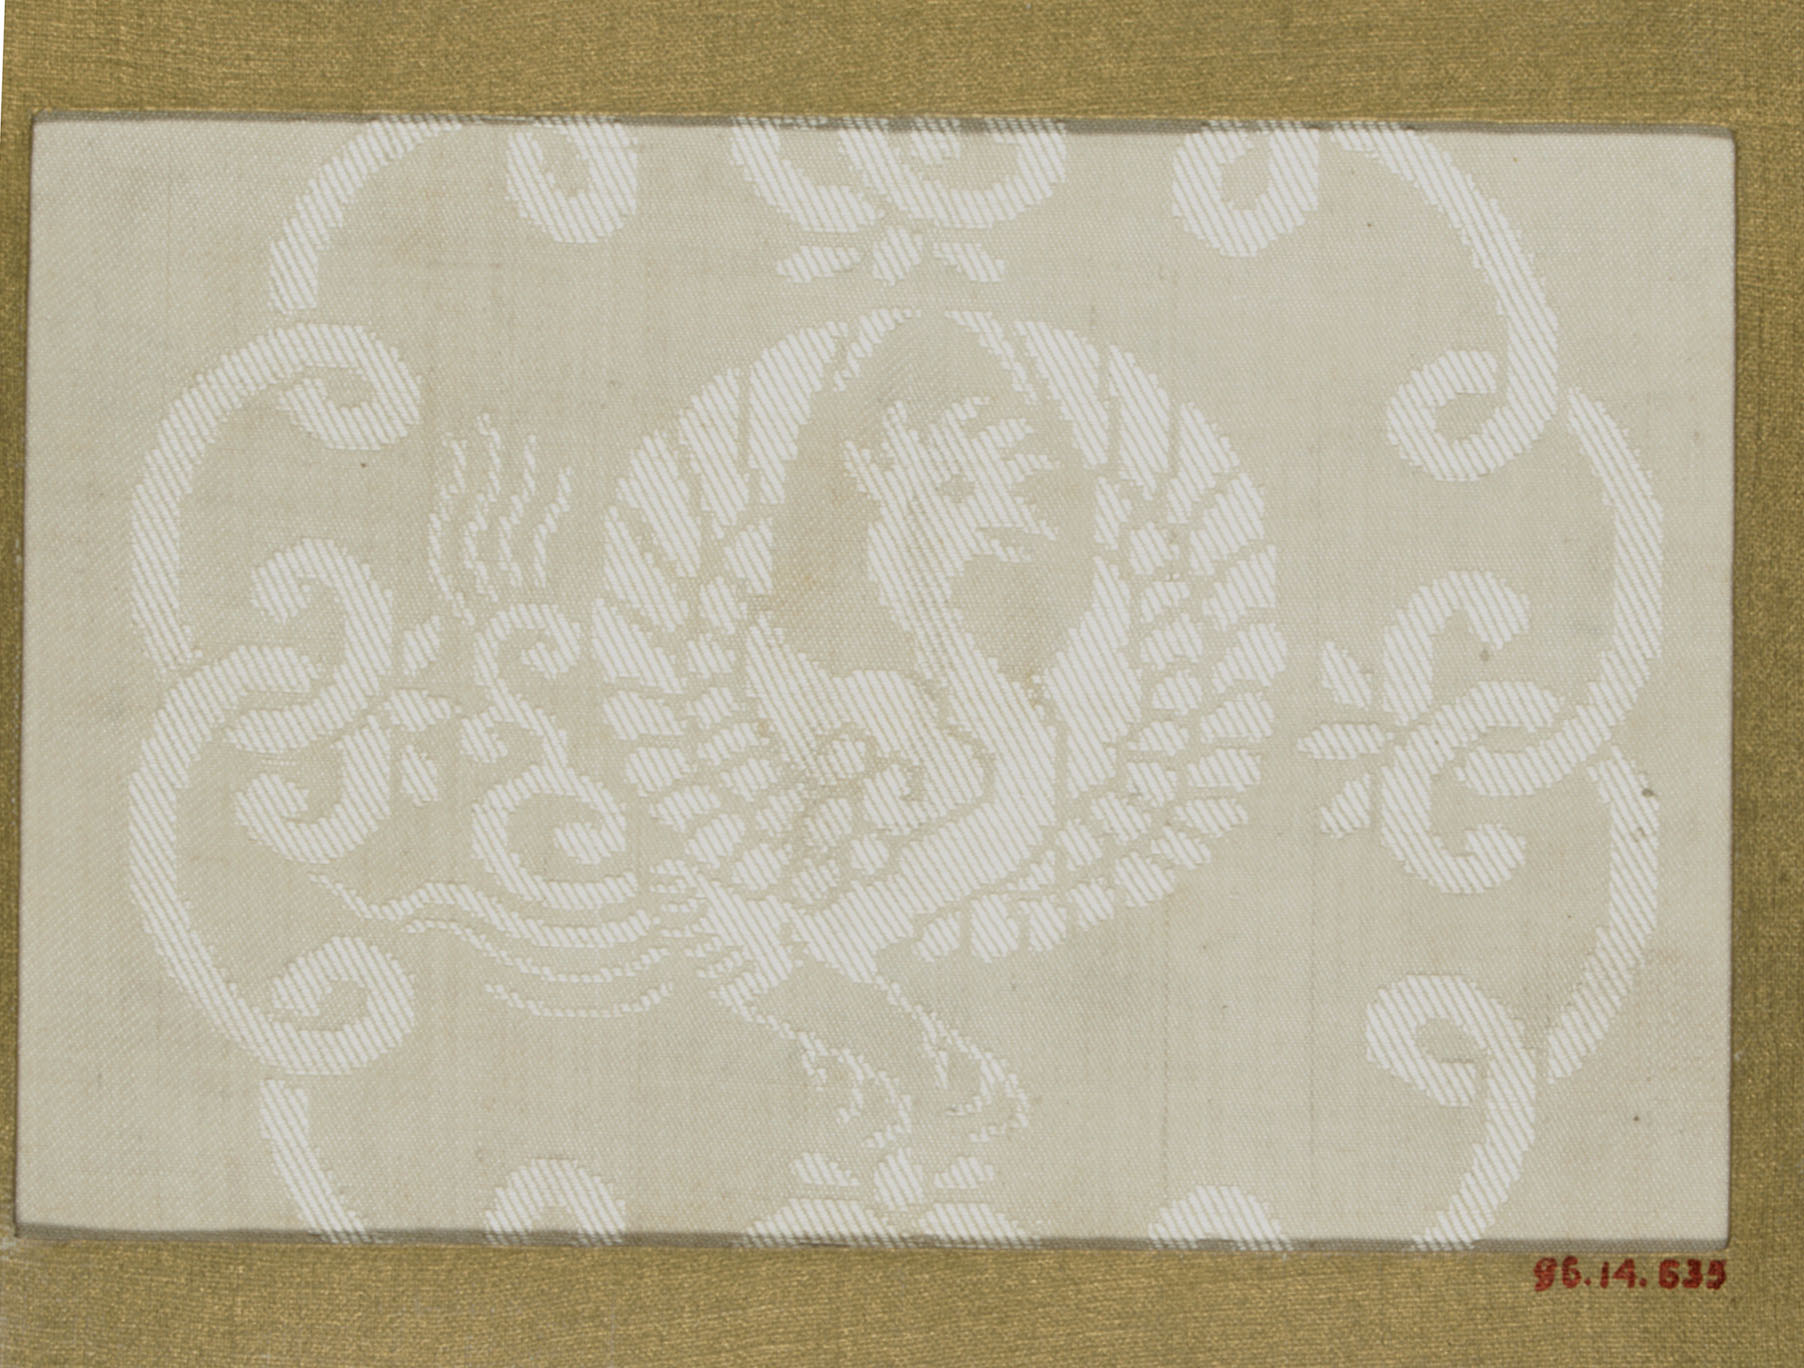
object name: piece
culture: japanese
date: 1701-1900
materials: silk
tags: phoenix